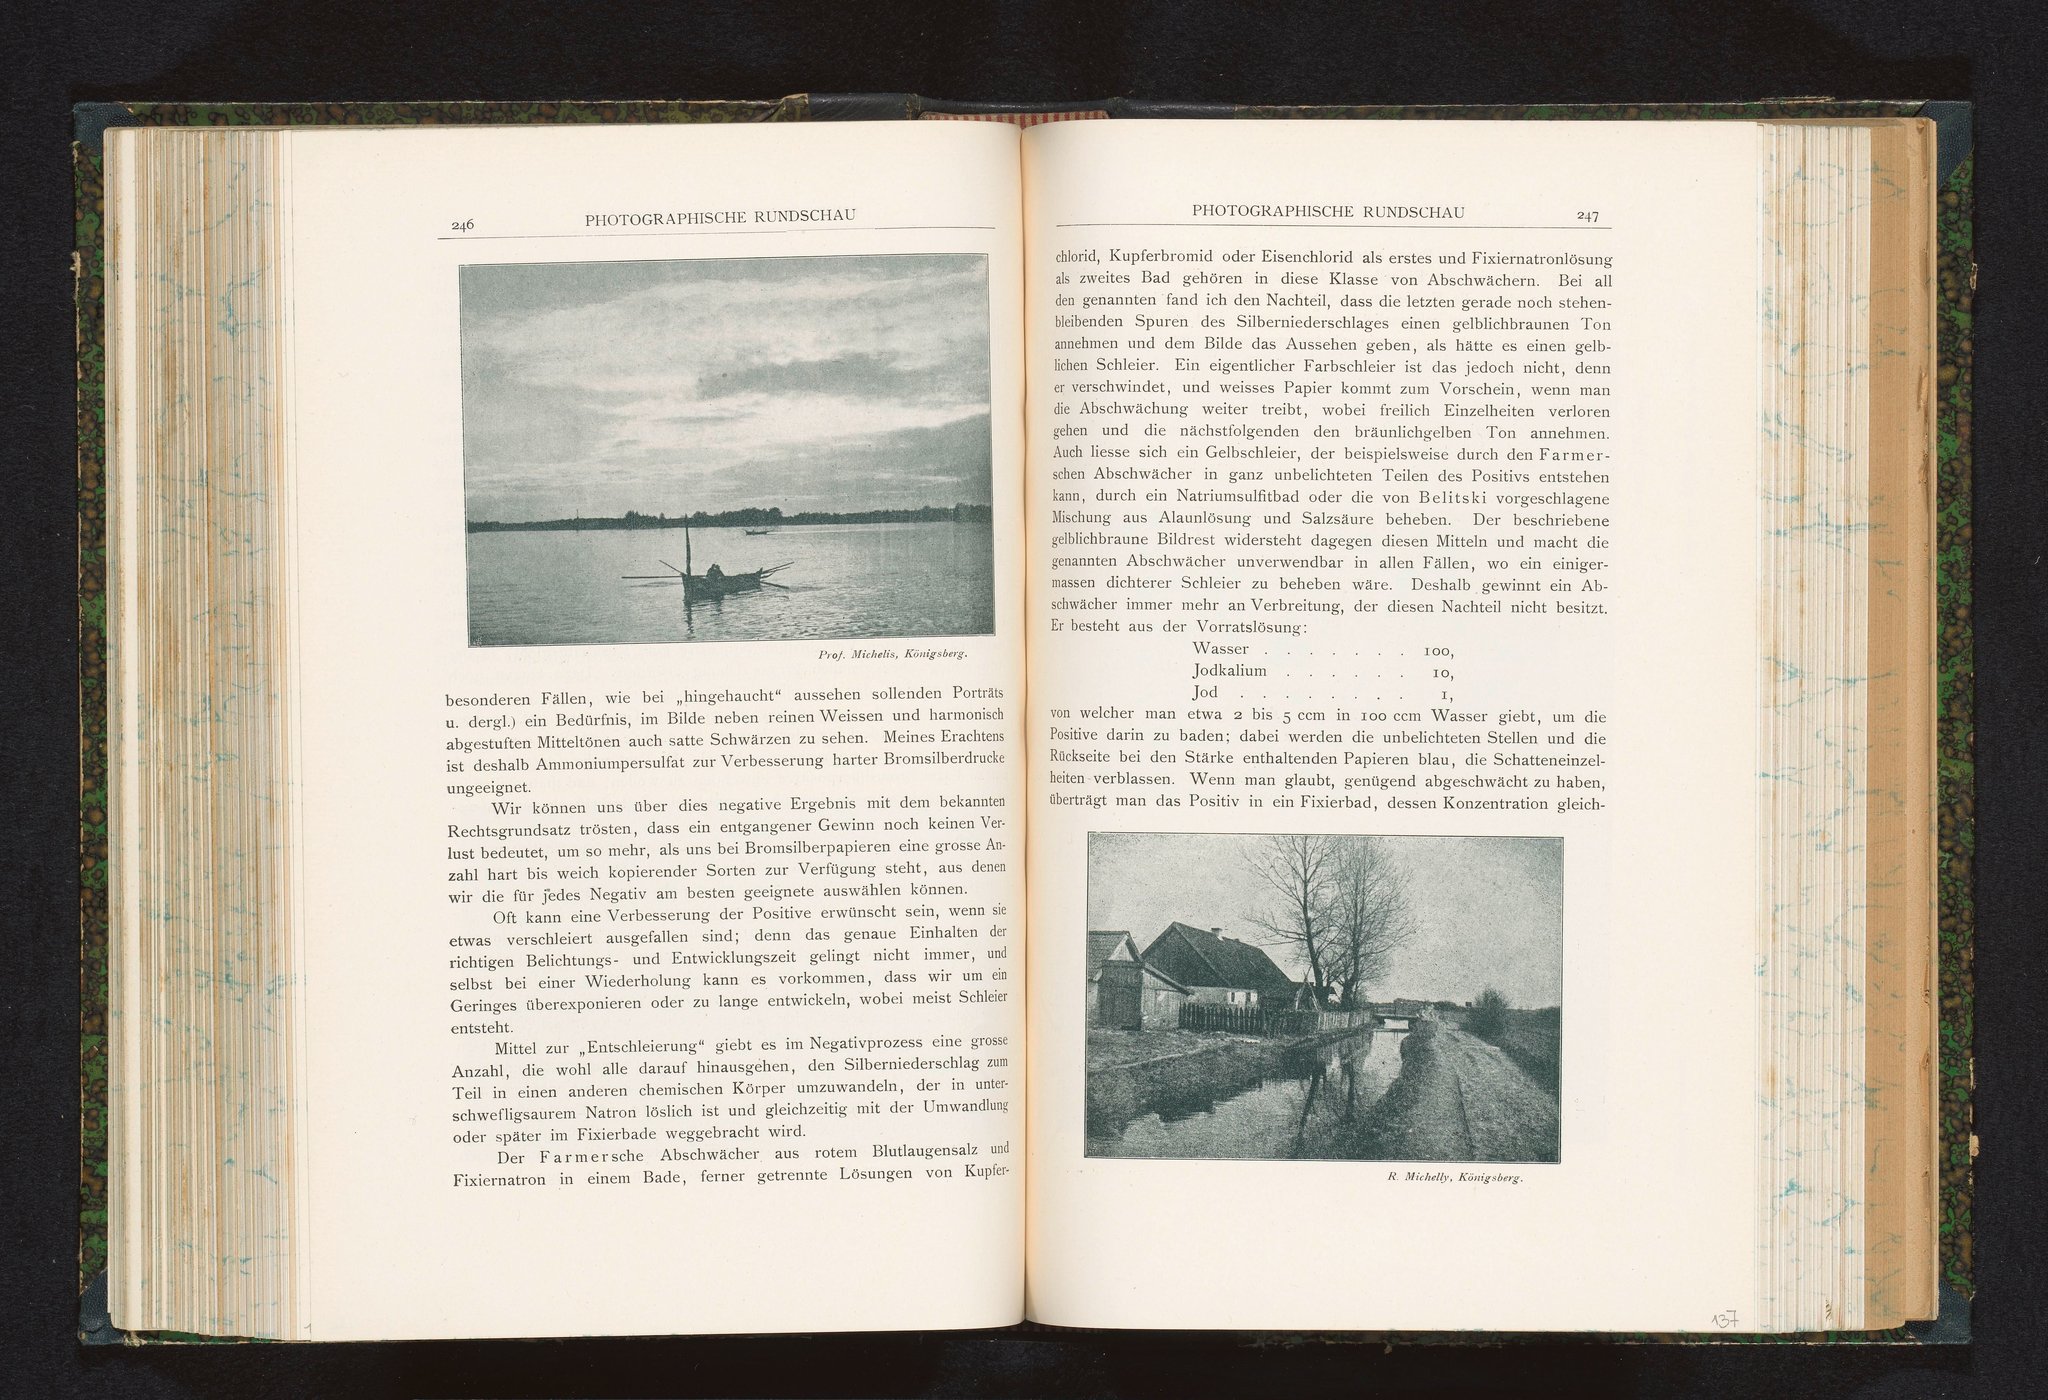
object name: photomechanical print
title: Huis naast een sloot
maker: r. michelly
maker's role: fotograaf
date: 1894-1899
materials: paper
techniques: autotype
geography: berlin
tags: rural housing, e.g. country-house, villa, cottage, small canal, ditch